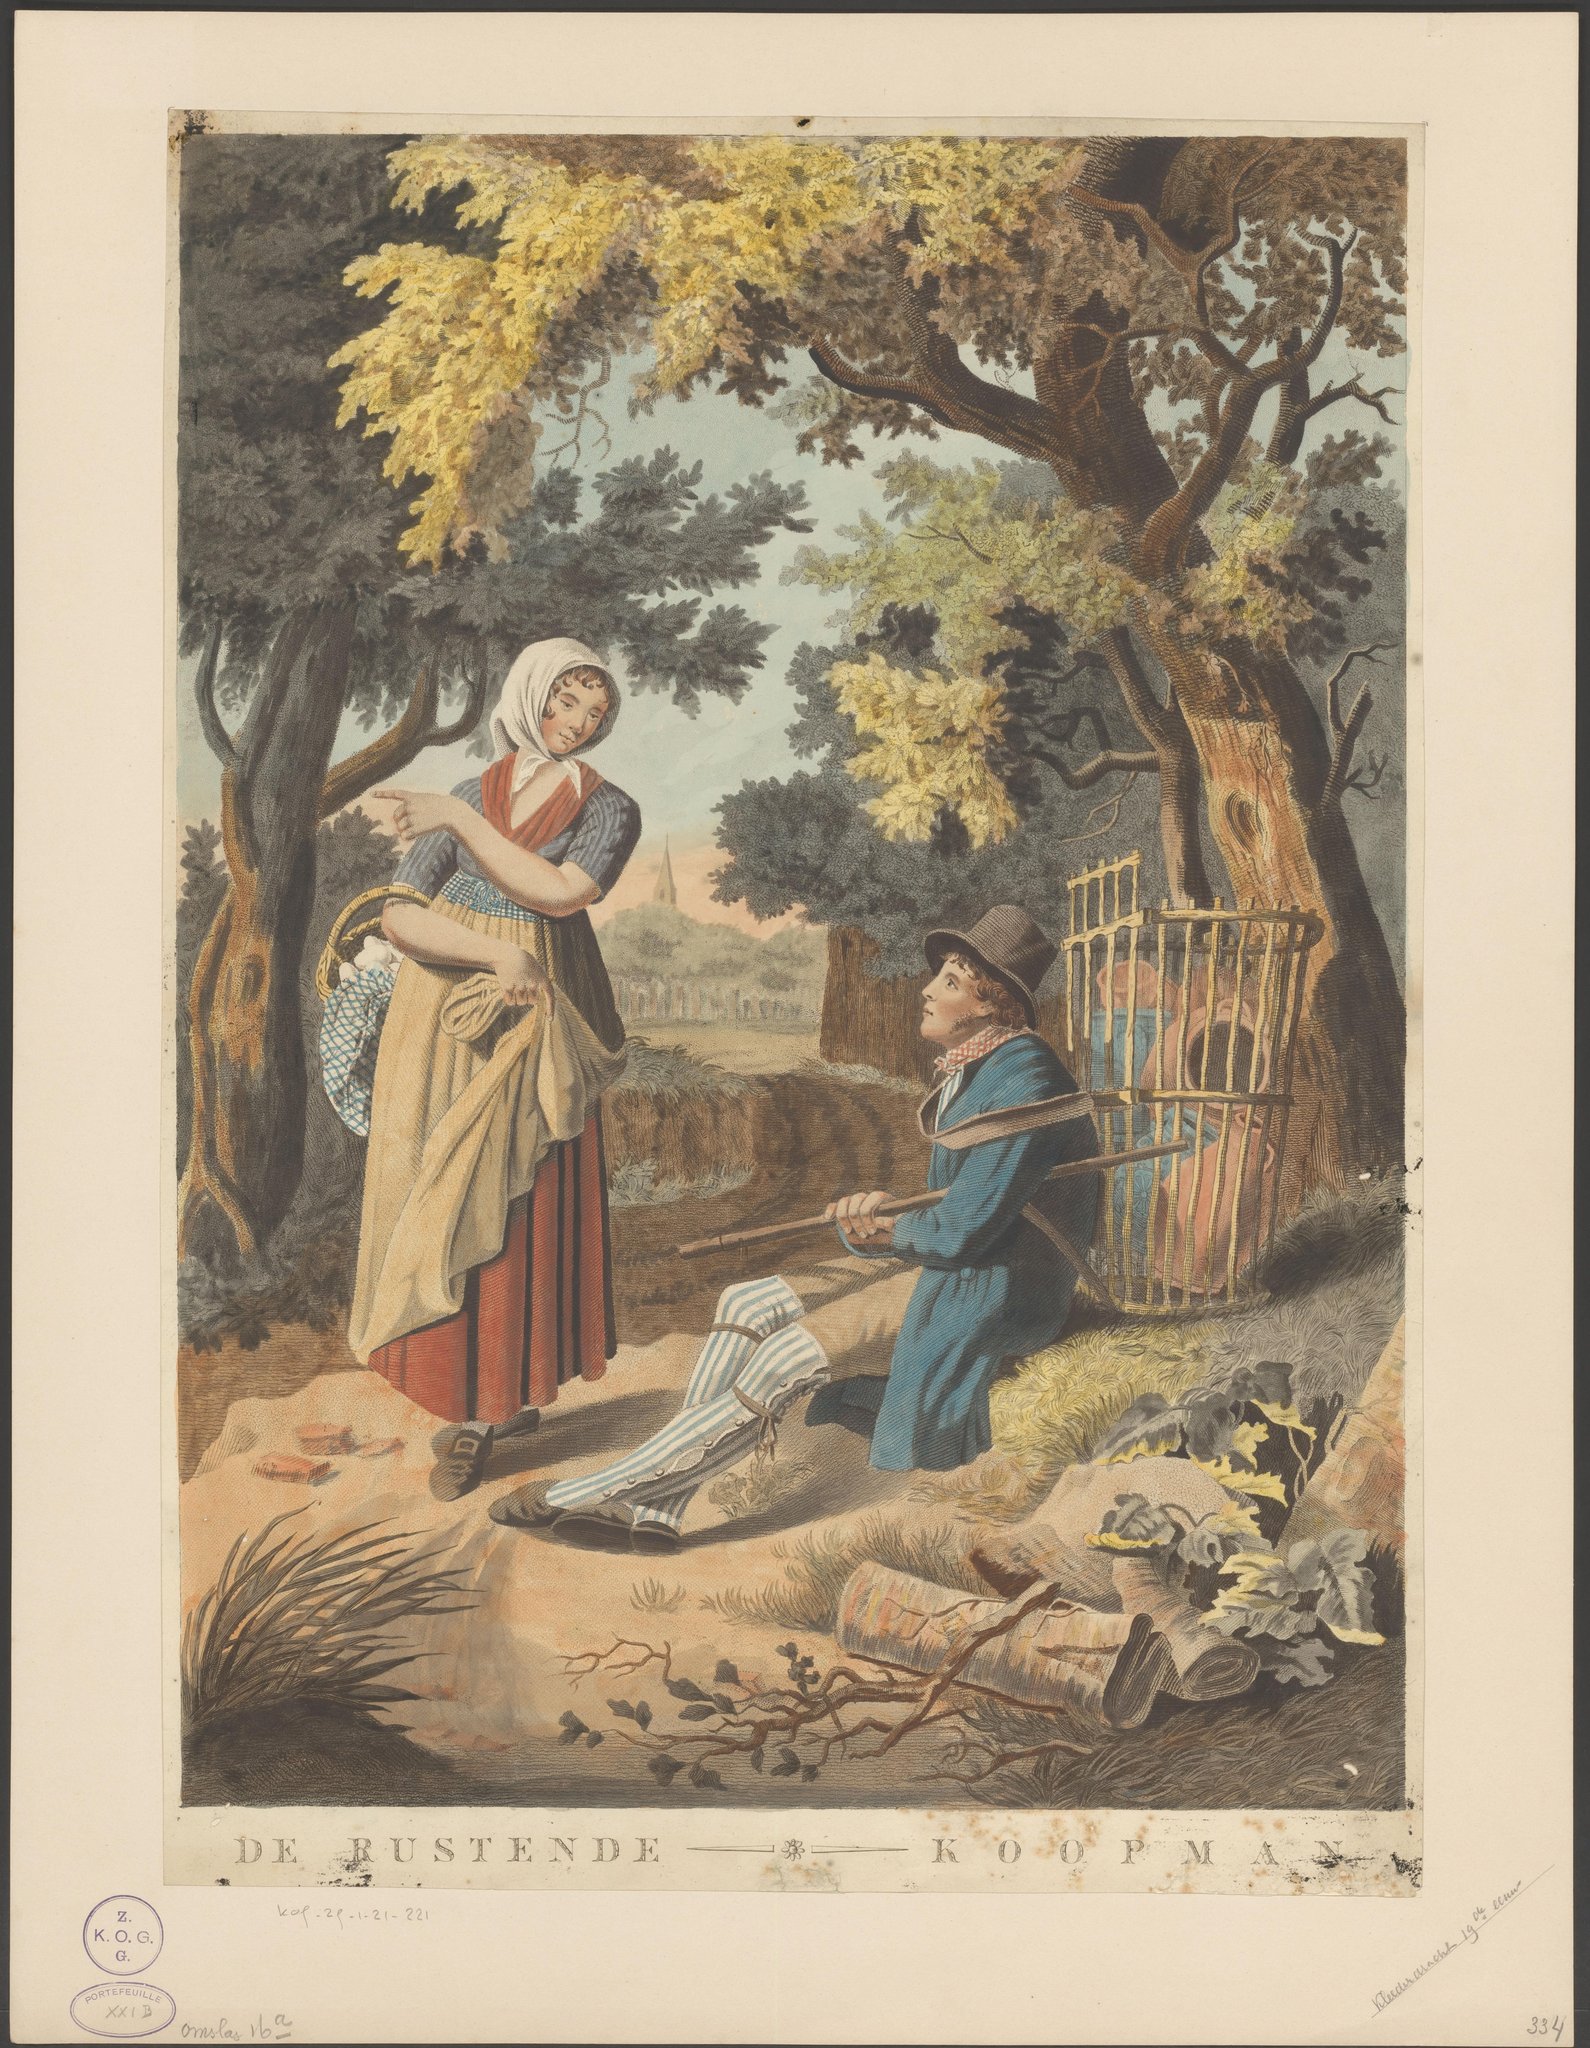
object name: print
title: De rustende koopman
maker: Anonymous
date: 1800-1849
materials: paper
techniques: etching, hand coloring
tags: adult woman, (traveller) resting in the open air, carrying something in basket, bag, rucksack, etc., eggs, egg-dishes, container of ceramics: jar, jug, pot, vase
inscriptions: collector's mark: Lugt 1641, stamp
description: Aardewerk verkoper rust langs het pad. Een vrouw met een mand eieren aan haar arm, wijst hem de weg. Onderwerpsrubrieken binnen de Atlas Zeden en Gewoonten: Zeden en Gewoonten in Engeren Zin, De Kleeding, Kleederdrachten (tijdvakken), Het begin der 19de eeuw. Mannen en vrouwen.